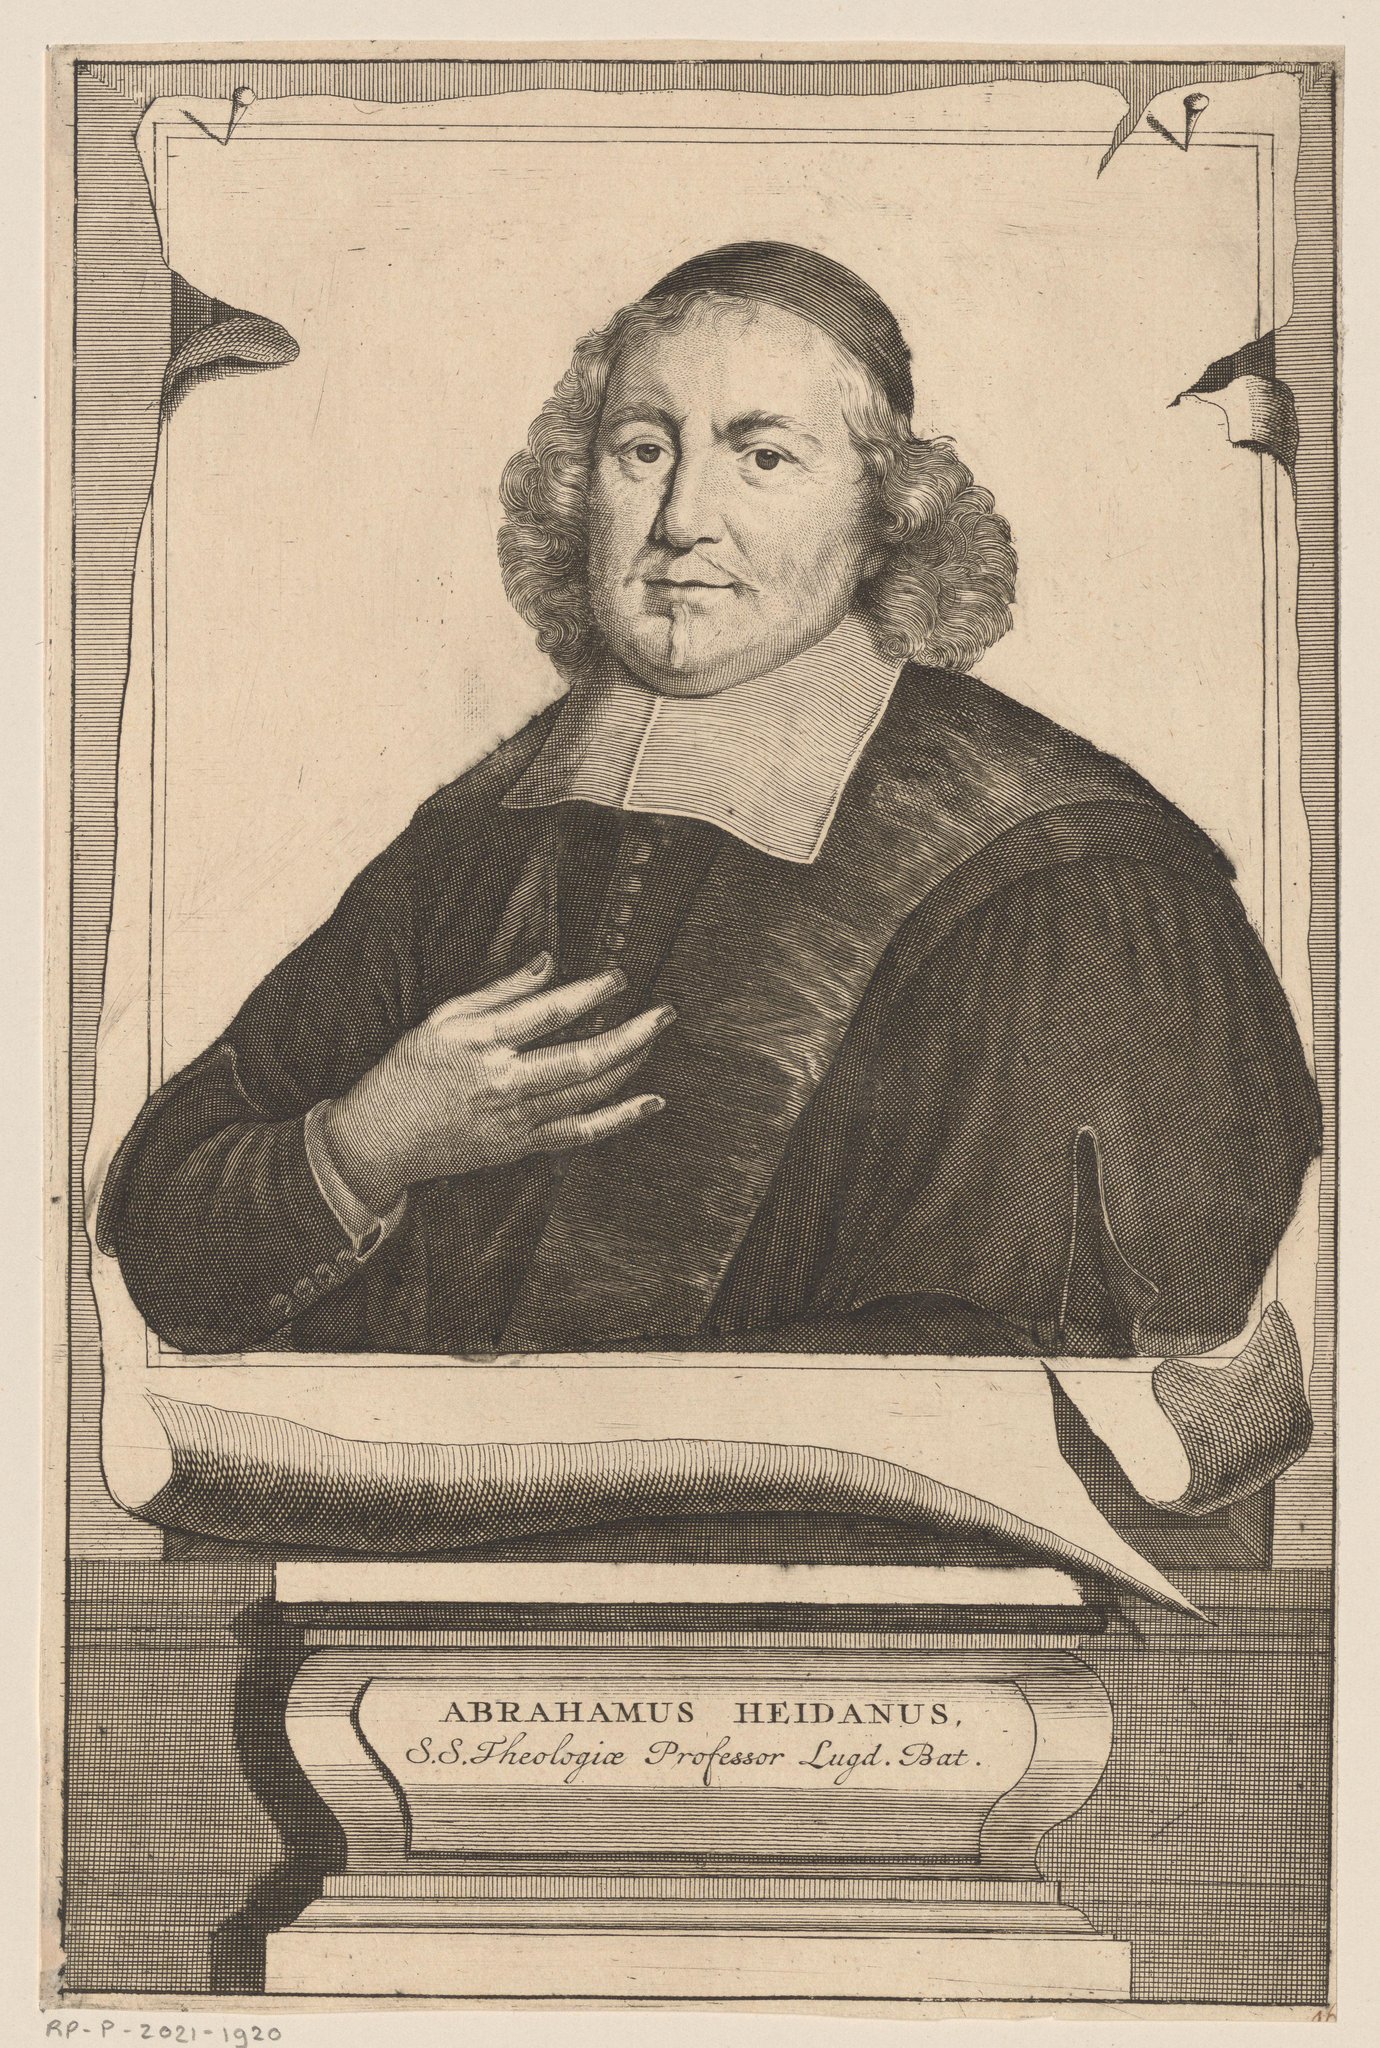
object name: print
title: Portret van Abraham Heidanus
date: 1716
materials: paper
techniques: engraving, etching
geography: leiden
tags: historical persons, functionaries and dignitaries ~ protestant churches